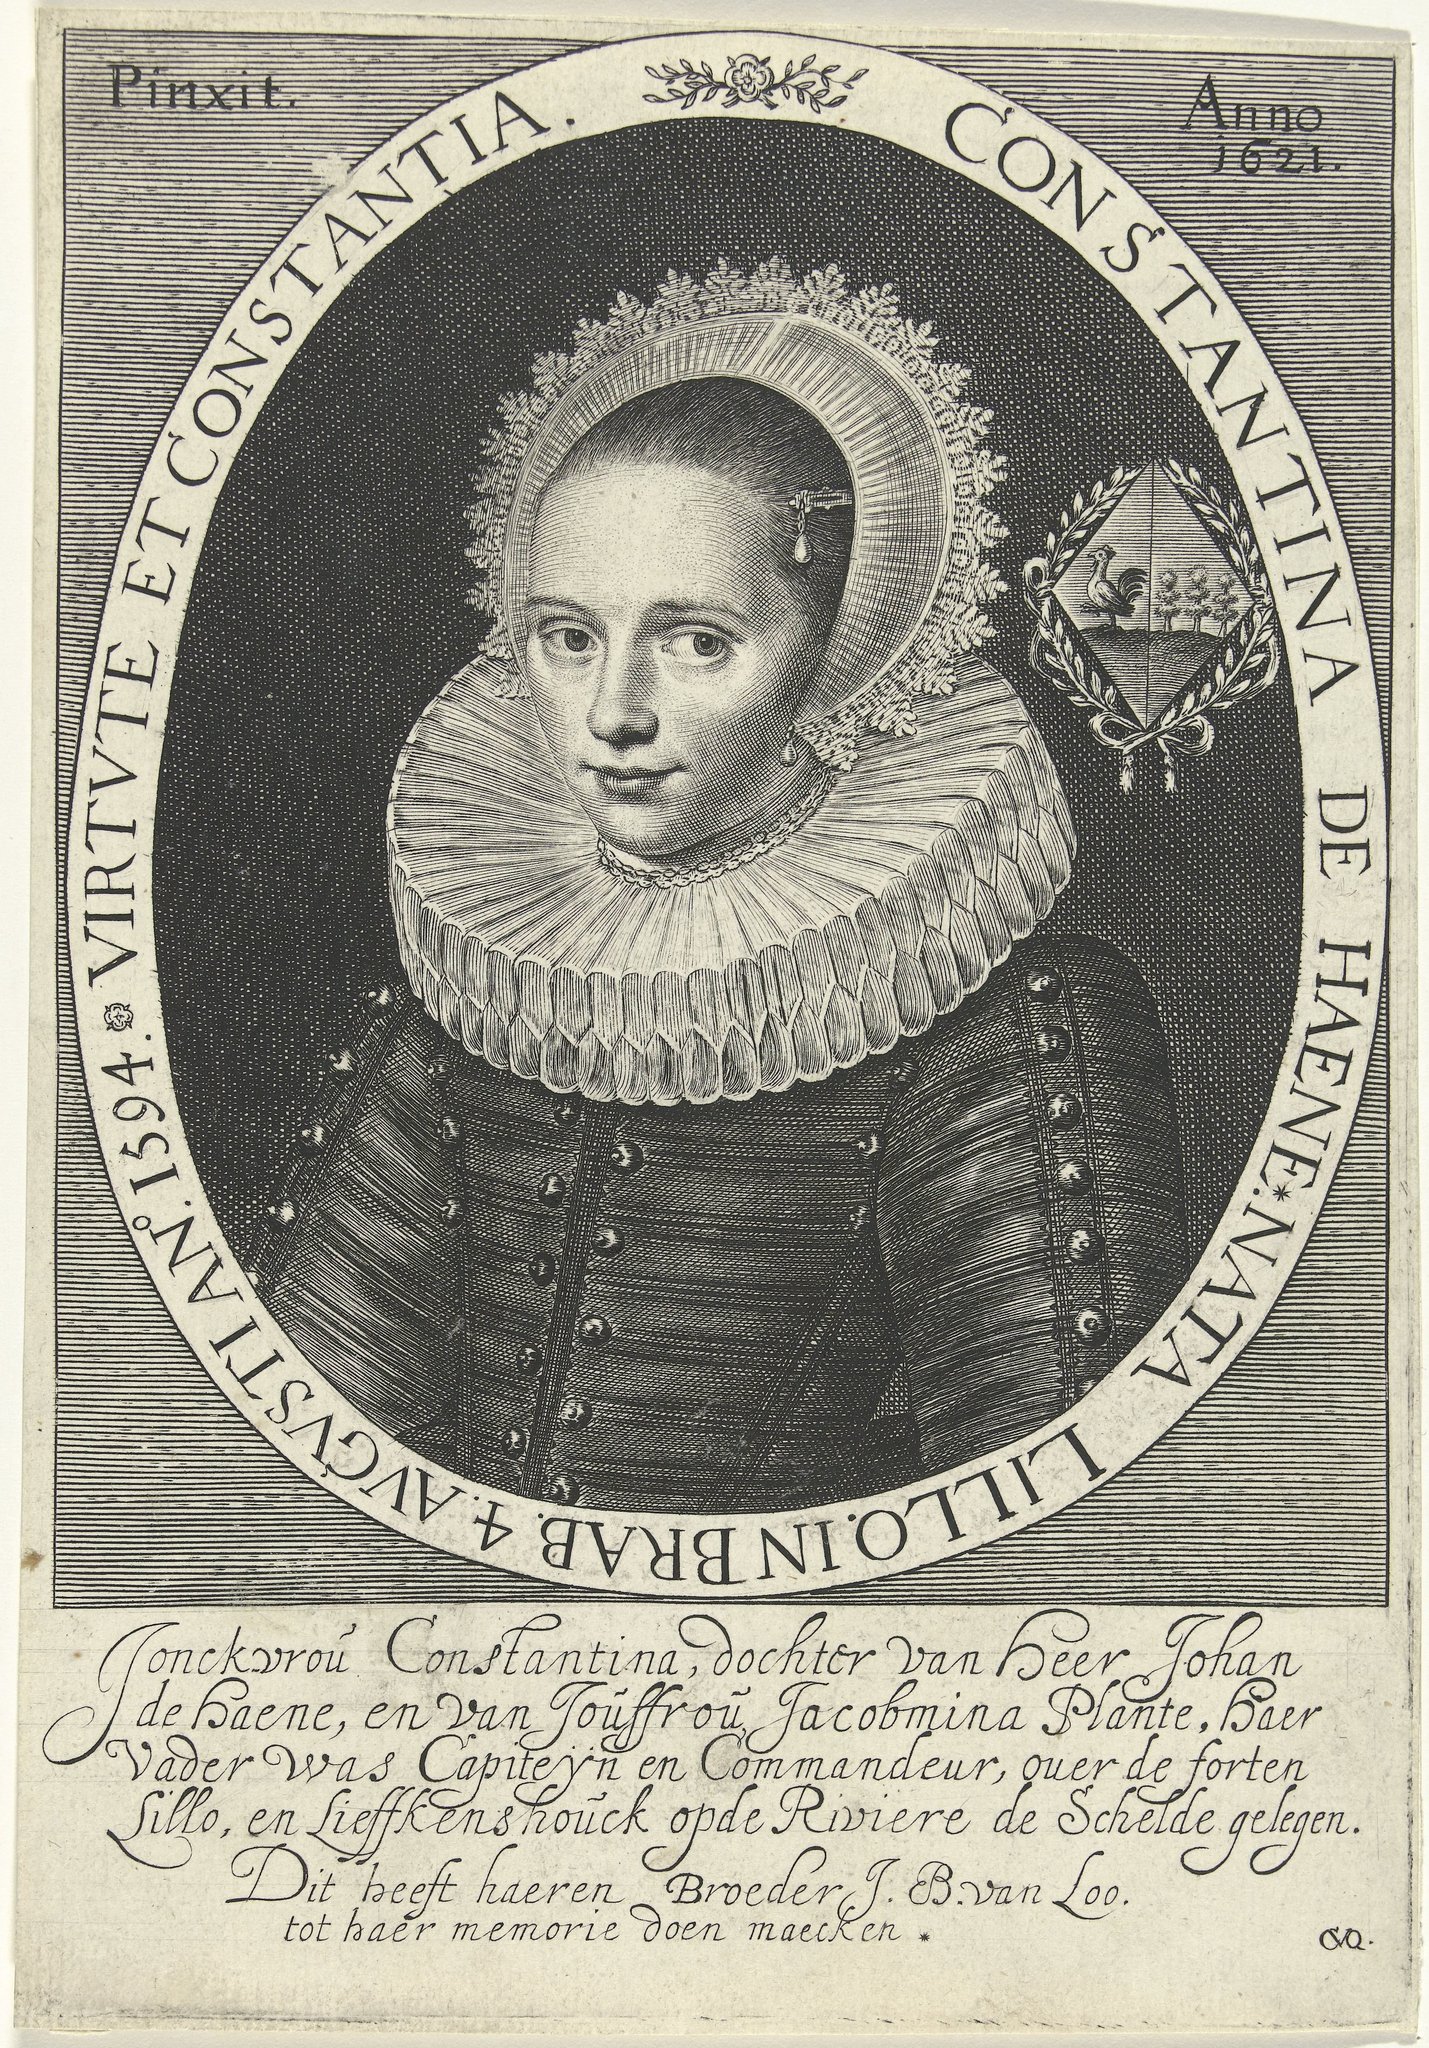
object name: print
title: Portret van Constantina de Haene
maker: crispijn van den queborn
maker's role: print maker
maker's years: 1595-1652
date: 1621-1652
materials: paper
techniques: engraving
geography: the hague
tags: constantina de haene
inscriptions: collector's mark: Lugt 2228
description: Portret van Constantina de Haene, ter gelegenheid van haar overlijden. Naast haar het familiewapen. Onder het portret haar naam en titels.